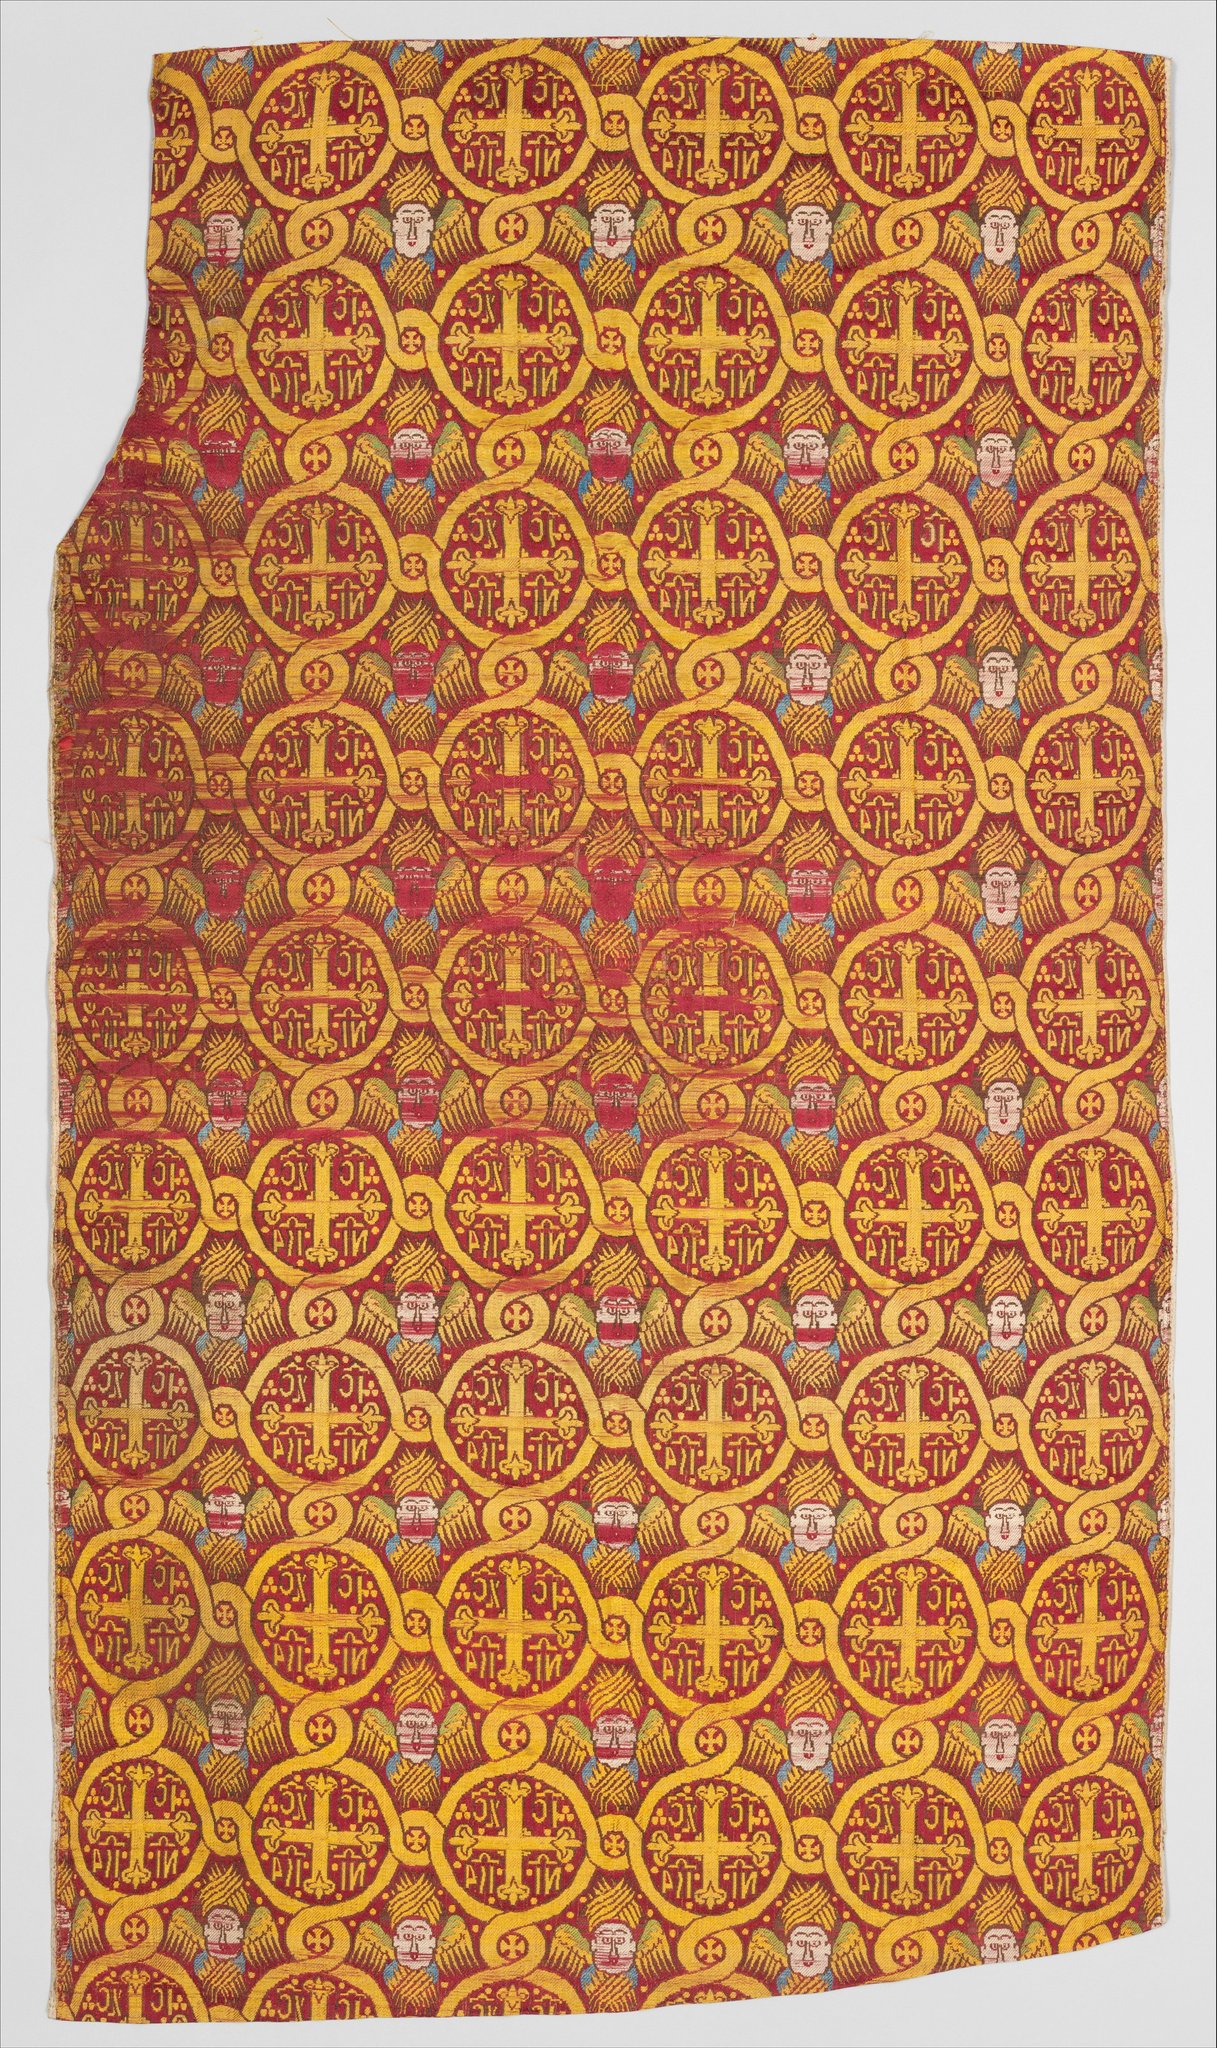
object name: woven silk length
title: Silk textile with Seraphim and Crosses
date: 1601-1700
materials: silk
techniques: lampas, weave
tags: angels,cross